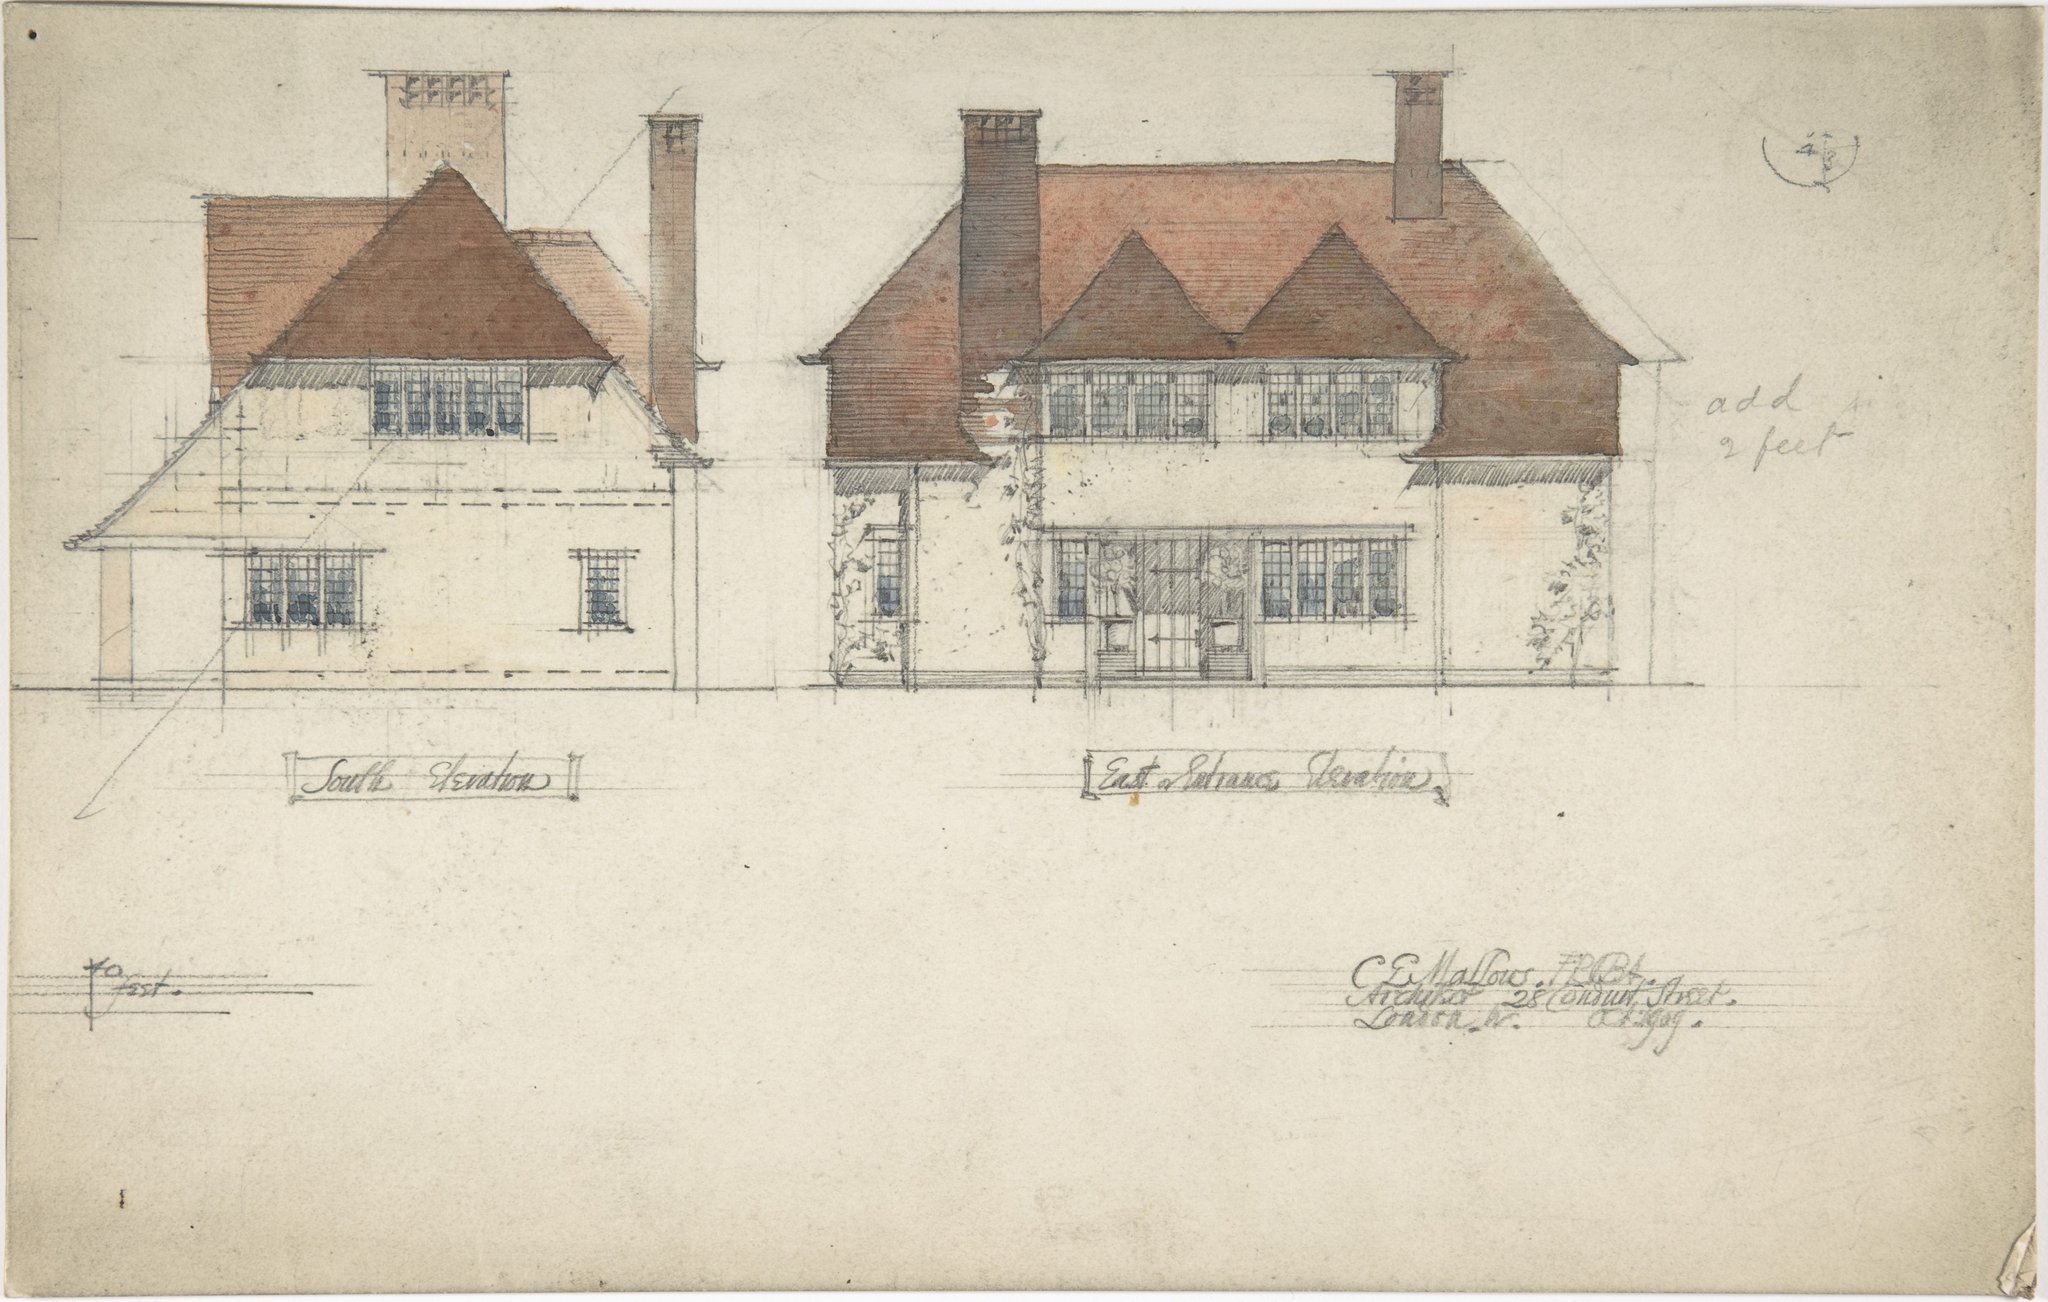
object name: drawing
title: South Elevation and East or Entrance Elevation of a House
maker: charles edward mallows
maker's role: artist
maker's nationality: british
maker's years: 1864-1915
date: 1909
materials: graphite, ink, watercolor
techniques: pen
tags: houses